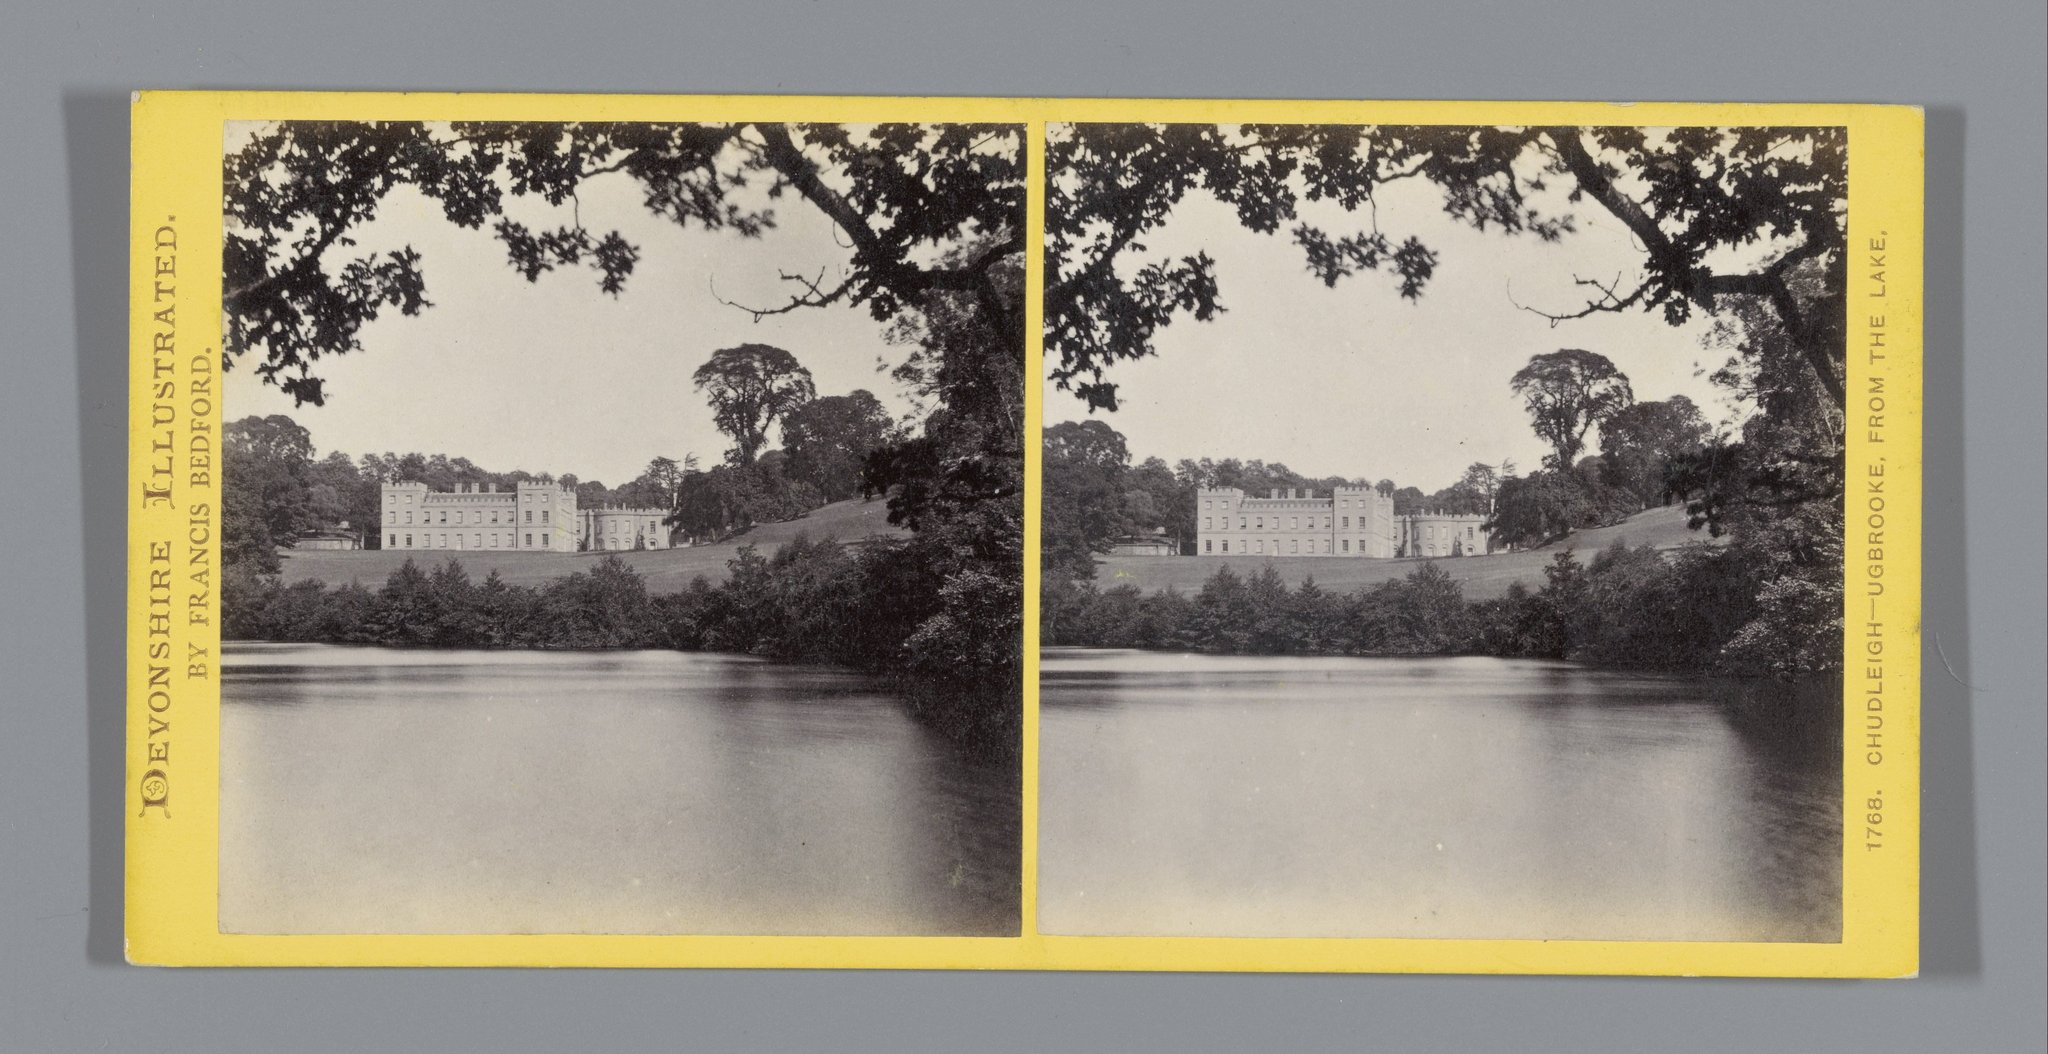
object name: stereograph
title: Gezicht op Ugbrooke te Chudleigh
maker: francis bedford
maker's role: print maker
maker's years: 1815-1894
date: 1850-1880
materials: cardboard, photographic support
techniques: albumen print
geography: ugbrooke park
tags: lake, façade (of house or building), country-house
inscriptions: number: ‘1768.’, inscription: ‘Devonshire Illustrated. by Francis Bedford.’